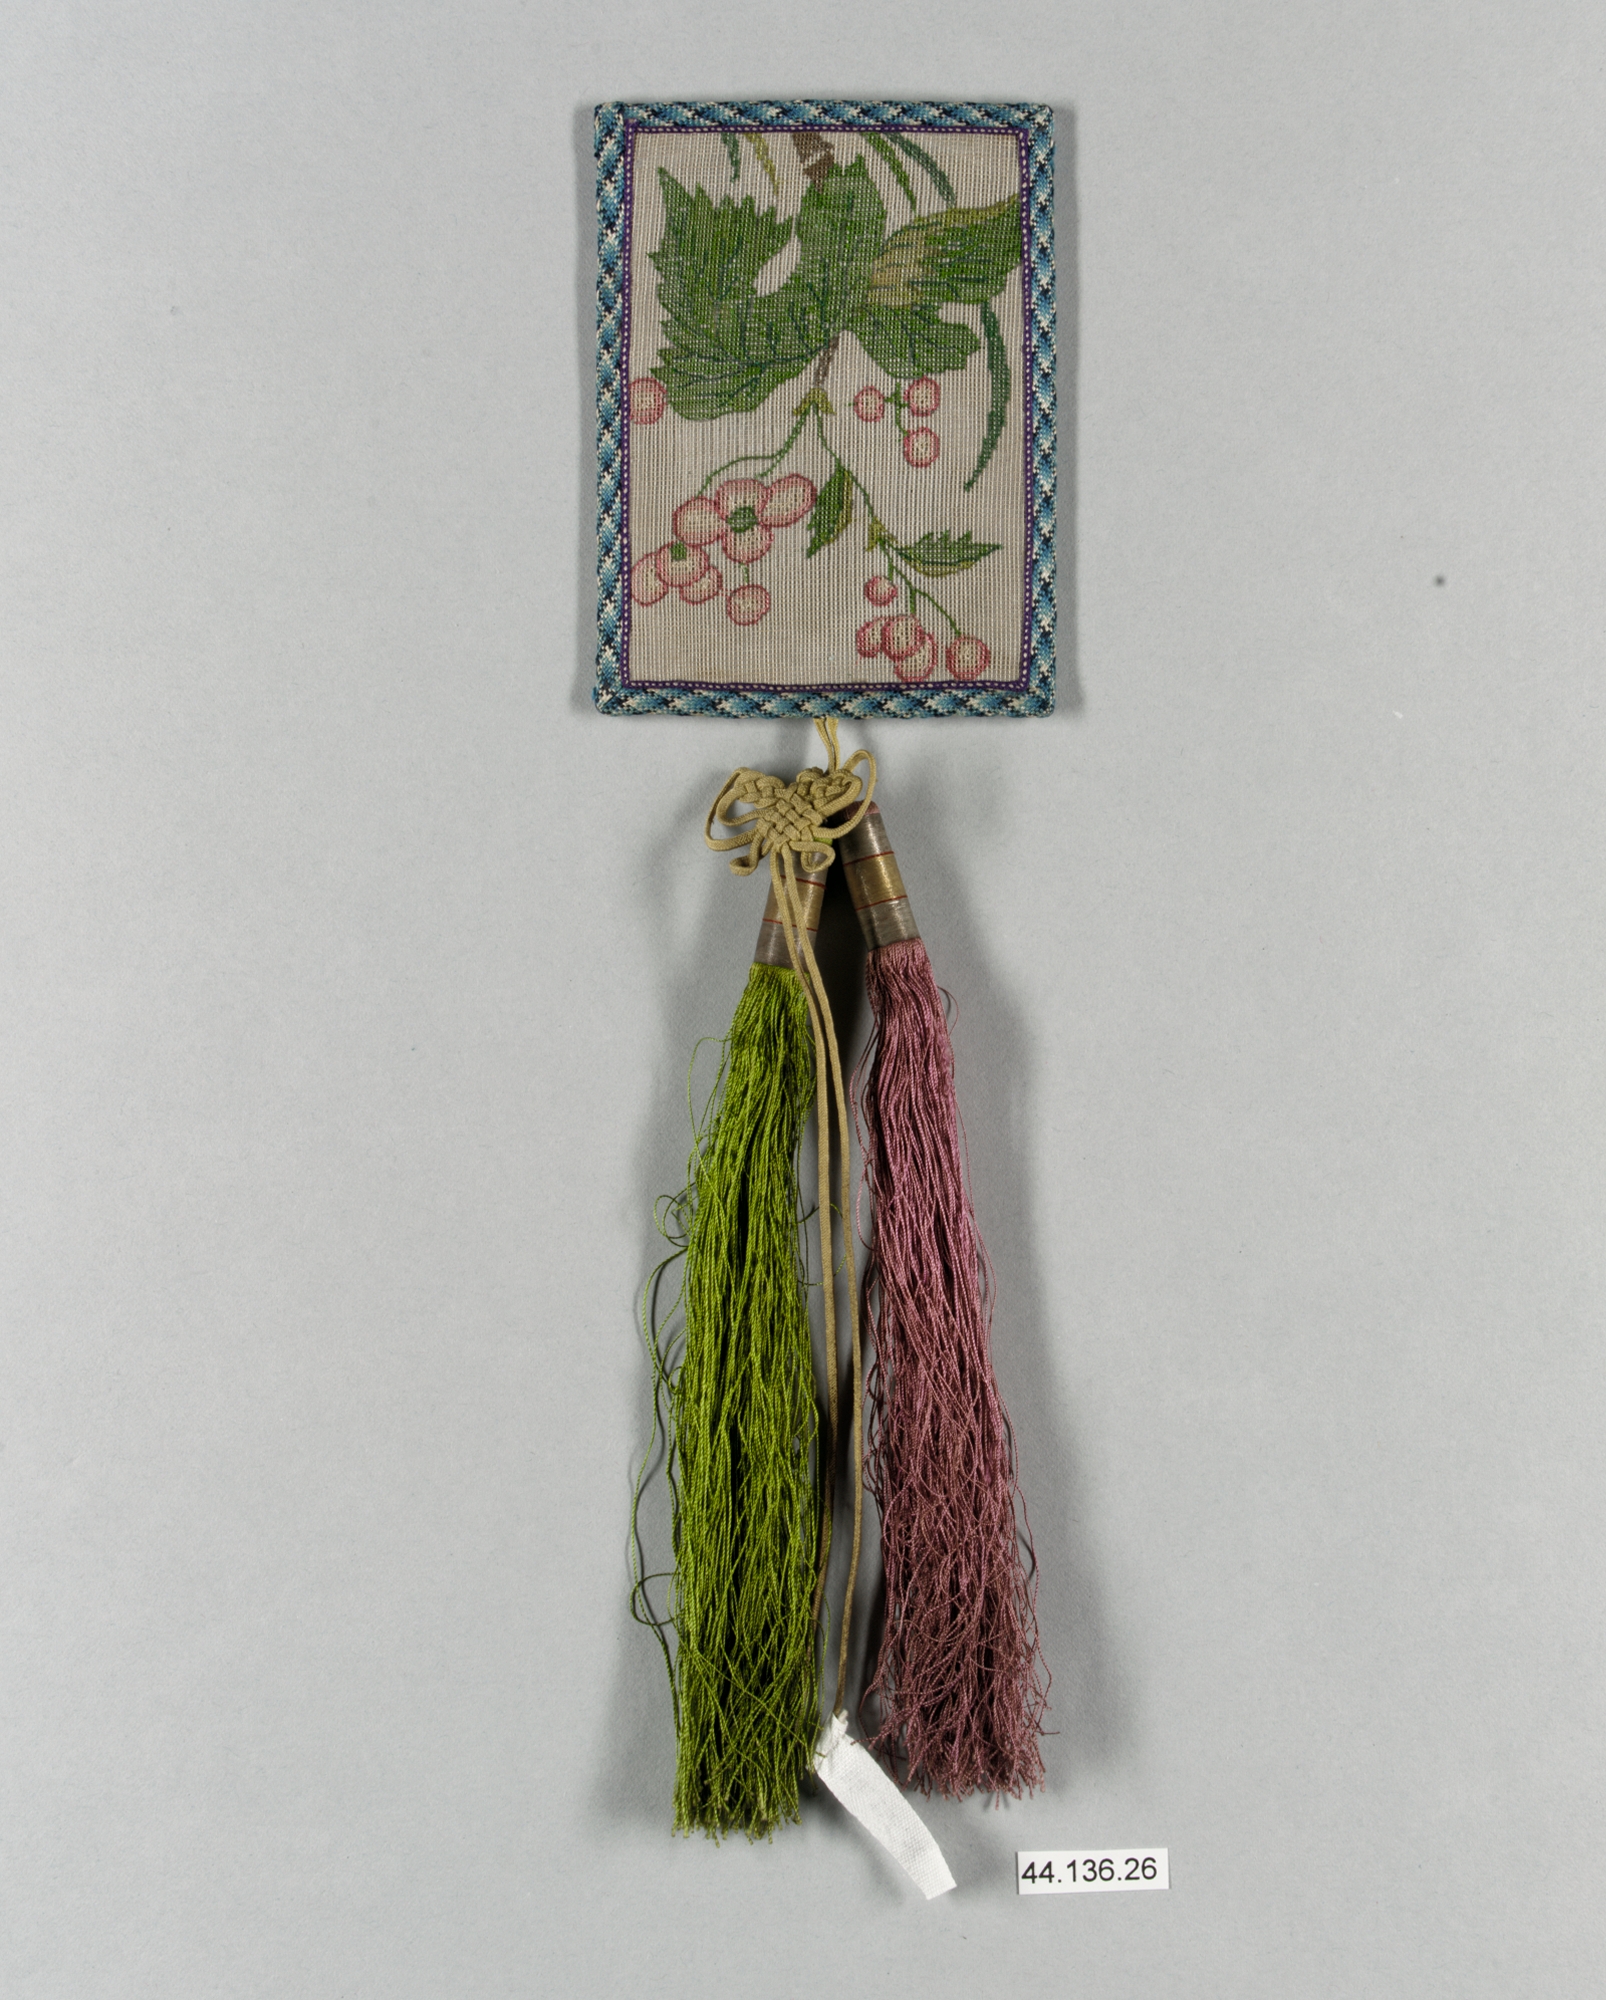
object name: mirror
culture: chinese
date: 1801-1900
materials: glass, silk